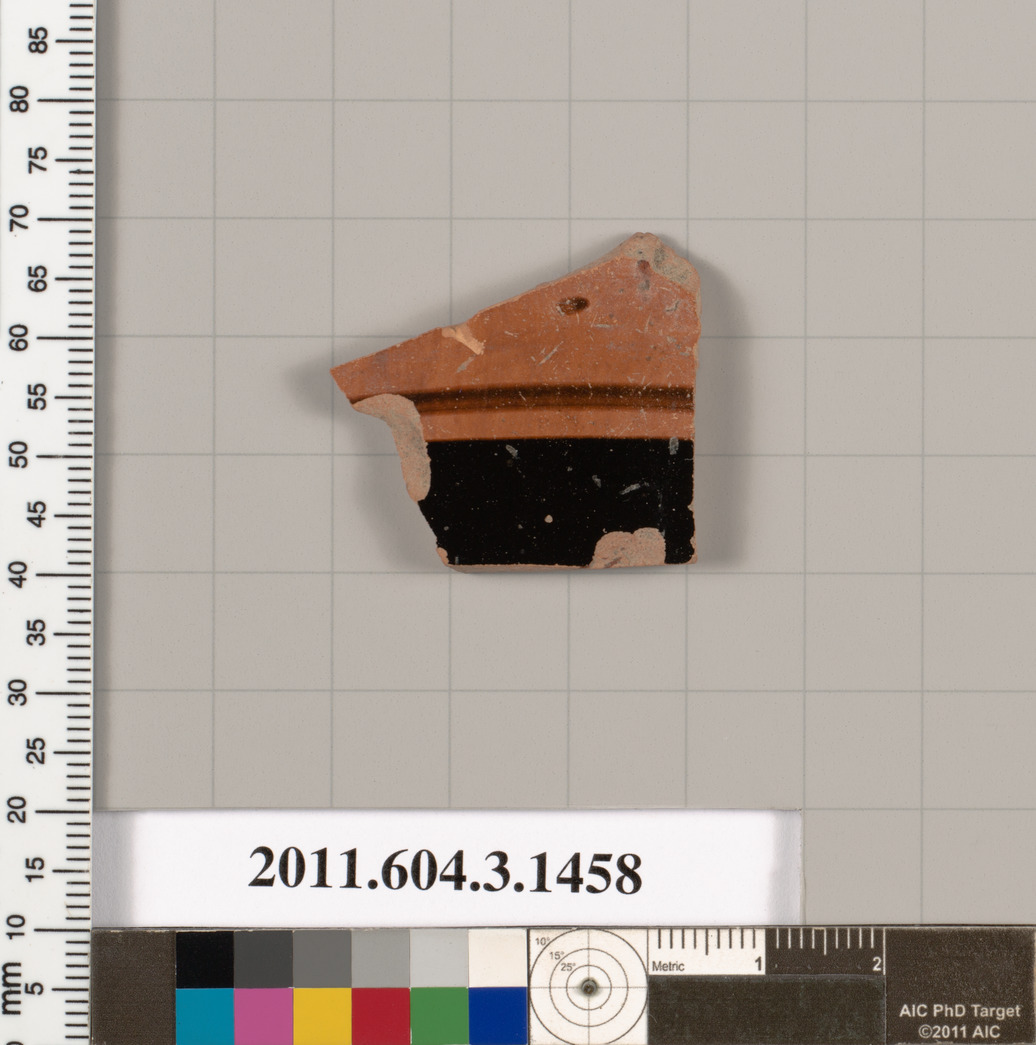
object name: skyphos fragment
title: Terracotta fragment of a skyphos (deep drinking cup)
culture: greek, attic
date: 600-401 BCE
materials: terracotta